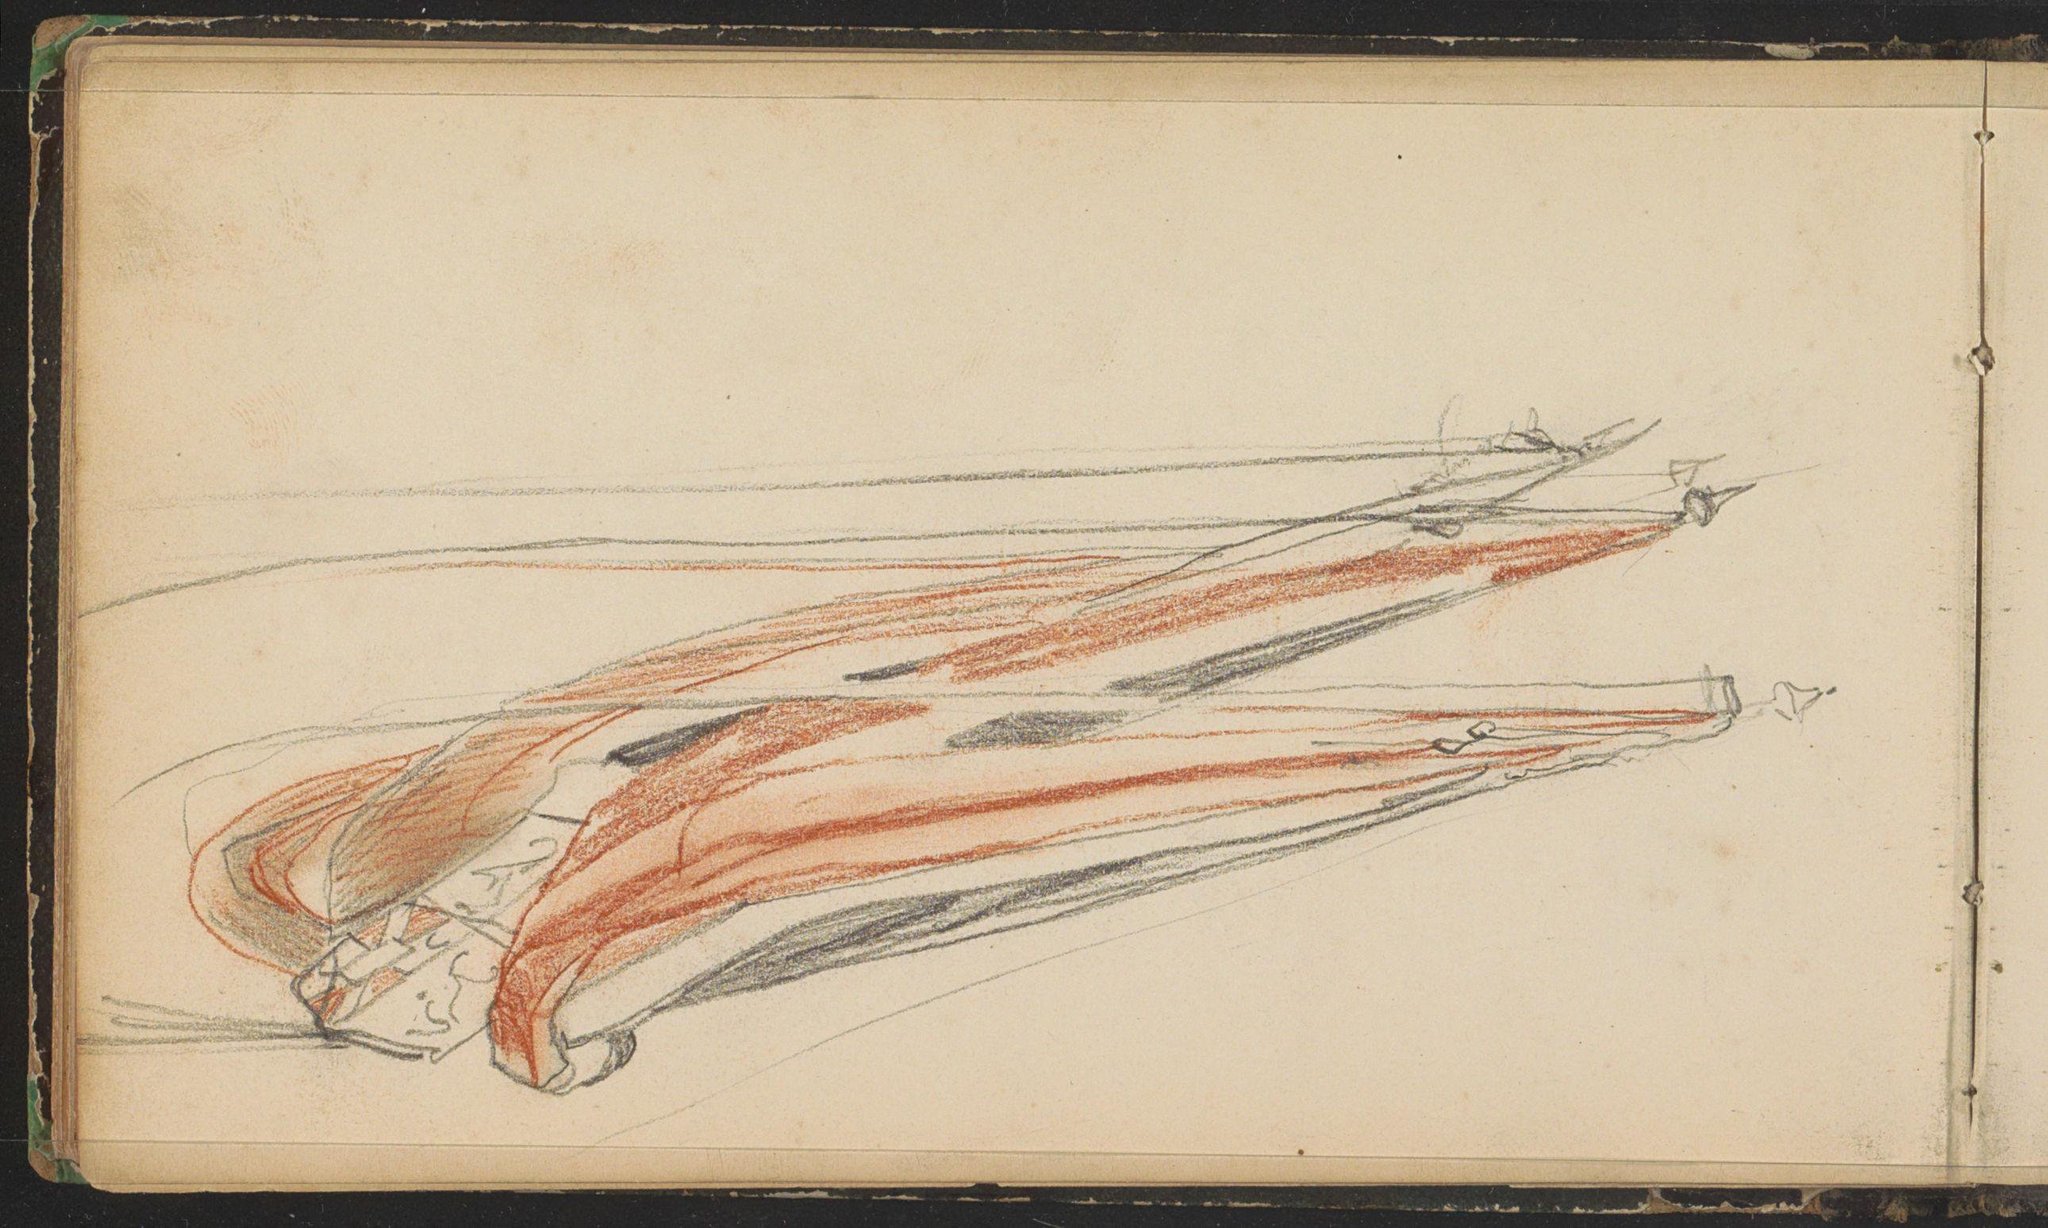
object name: sketchbook leaf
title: Wapen met vaandels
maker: johannes bosboom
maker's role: draughtsman, painter, print maker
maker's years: 1817-1891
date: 1845-1891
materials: chalk, paper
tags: banner, standard (as symbol of the state, etc.), armorial bearing, heraldry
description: Blad 45 verso uit een schetsboek met 46 bladen.